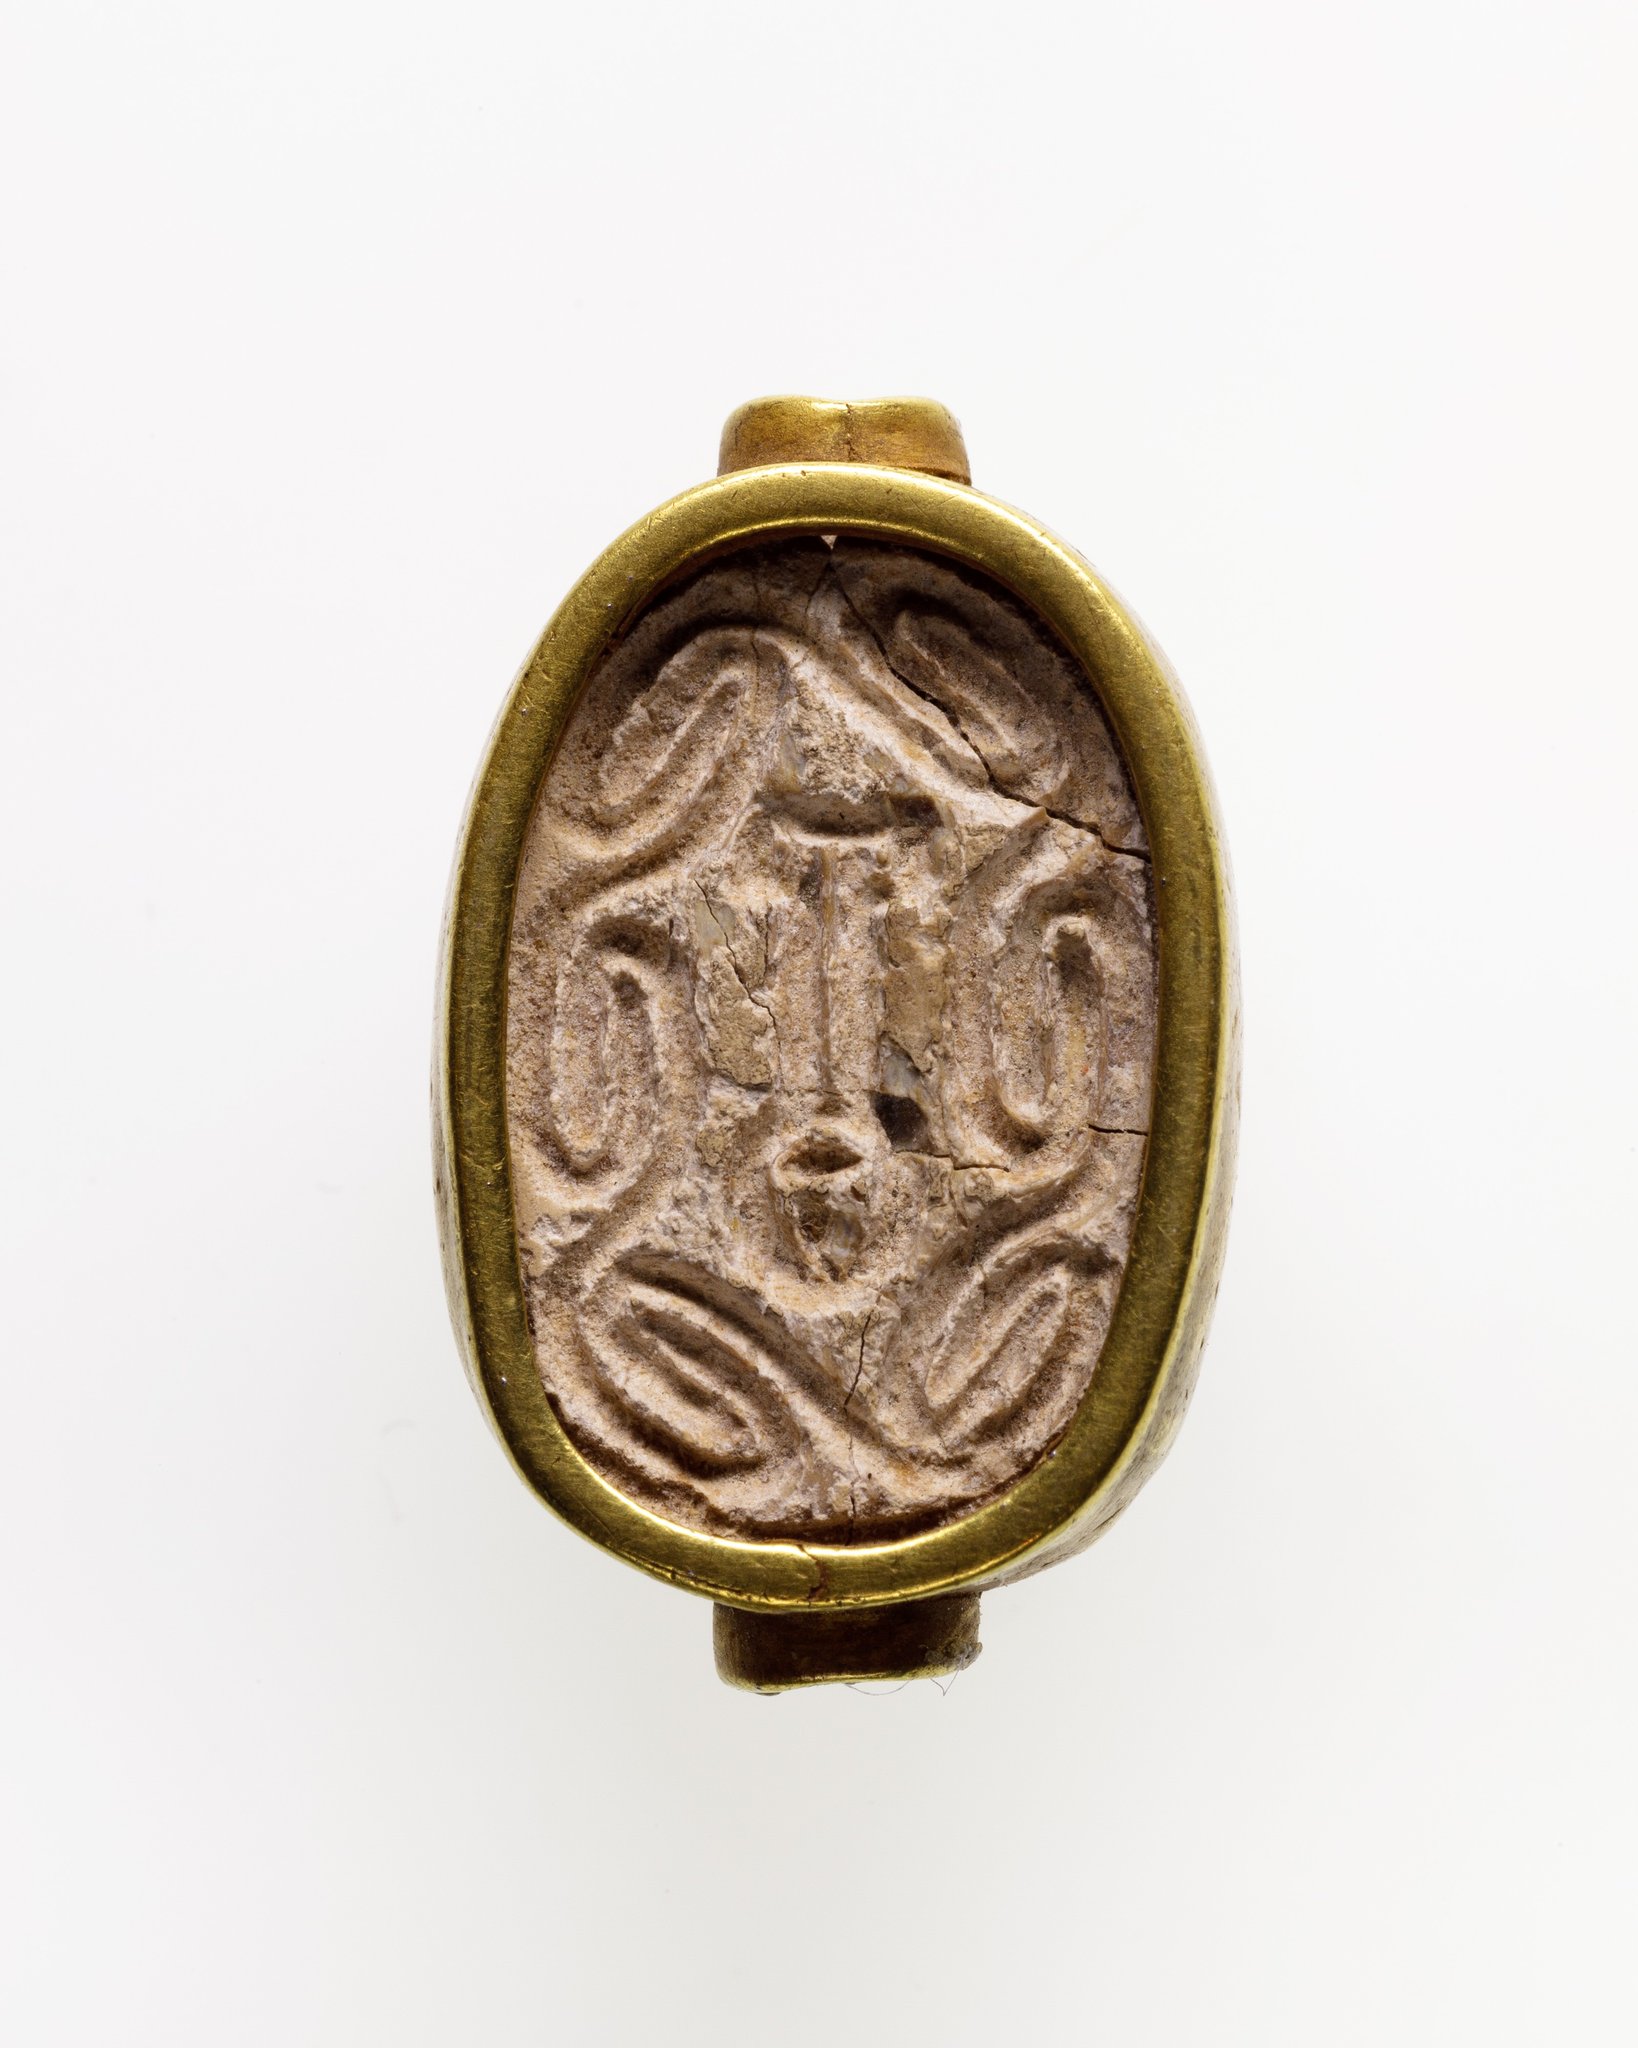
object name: scarab, nefer, scroll, ring mounting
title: Mounted Scarab Incised with Nefer Sign in Scroll Border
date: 1850-1640 BCE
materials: gold, stone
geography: egypt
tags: scarabs